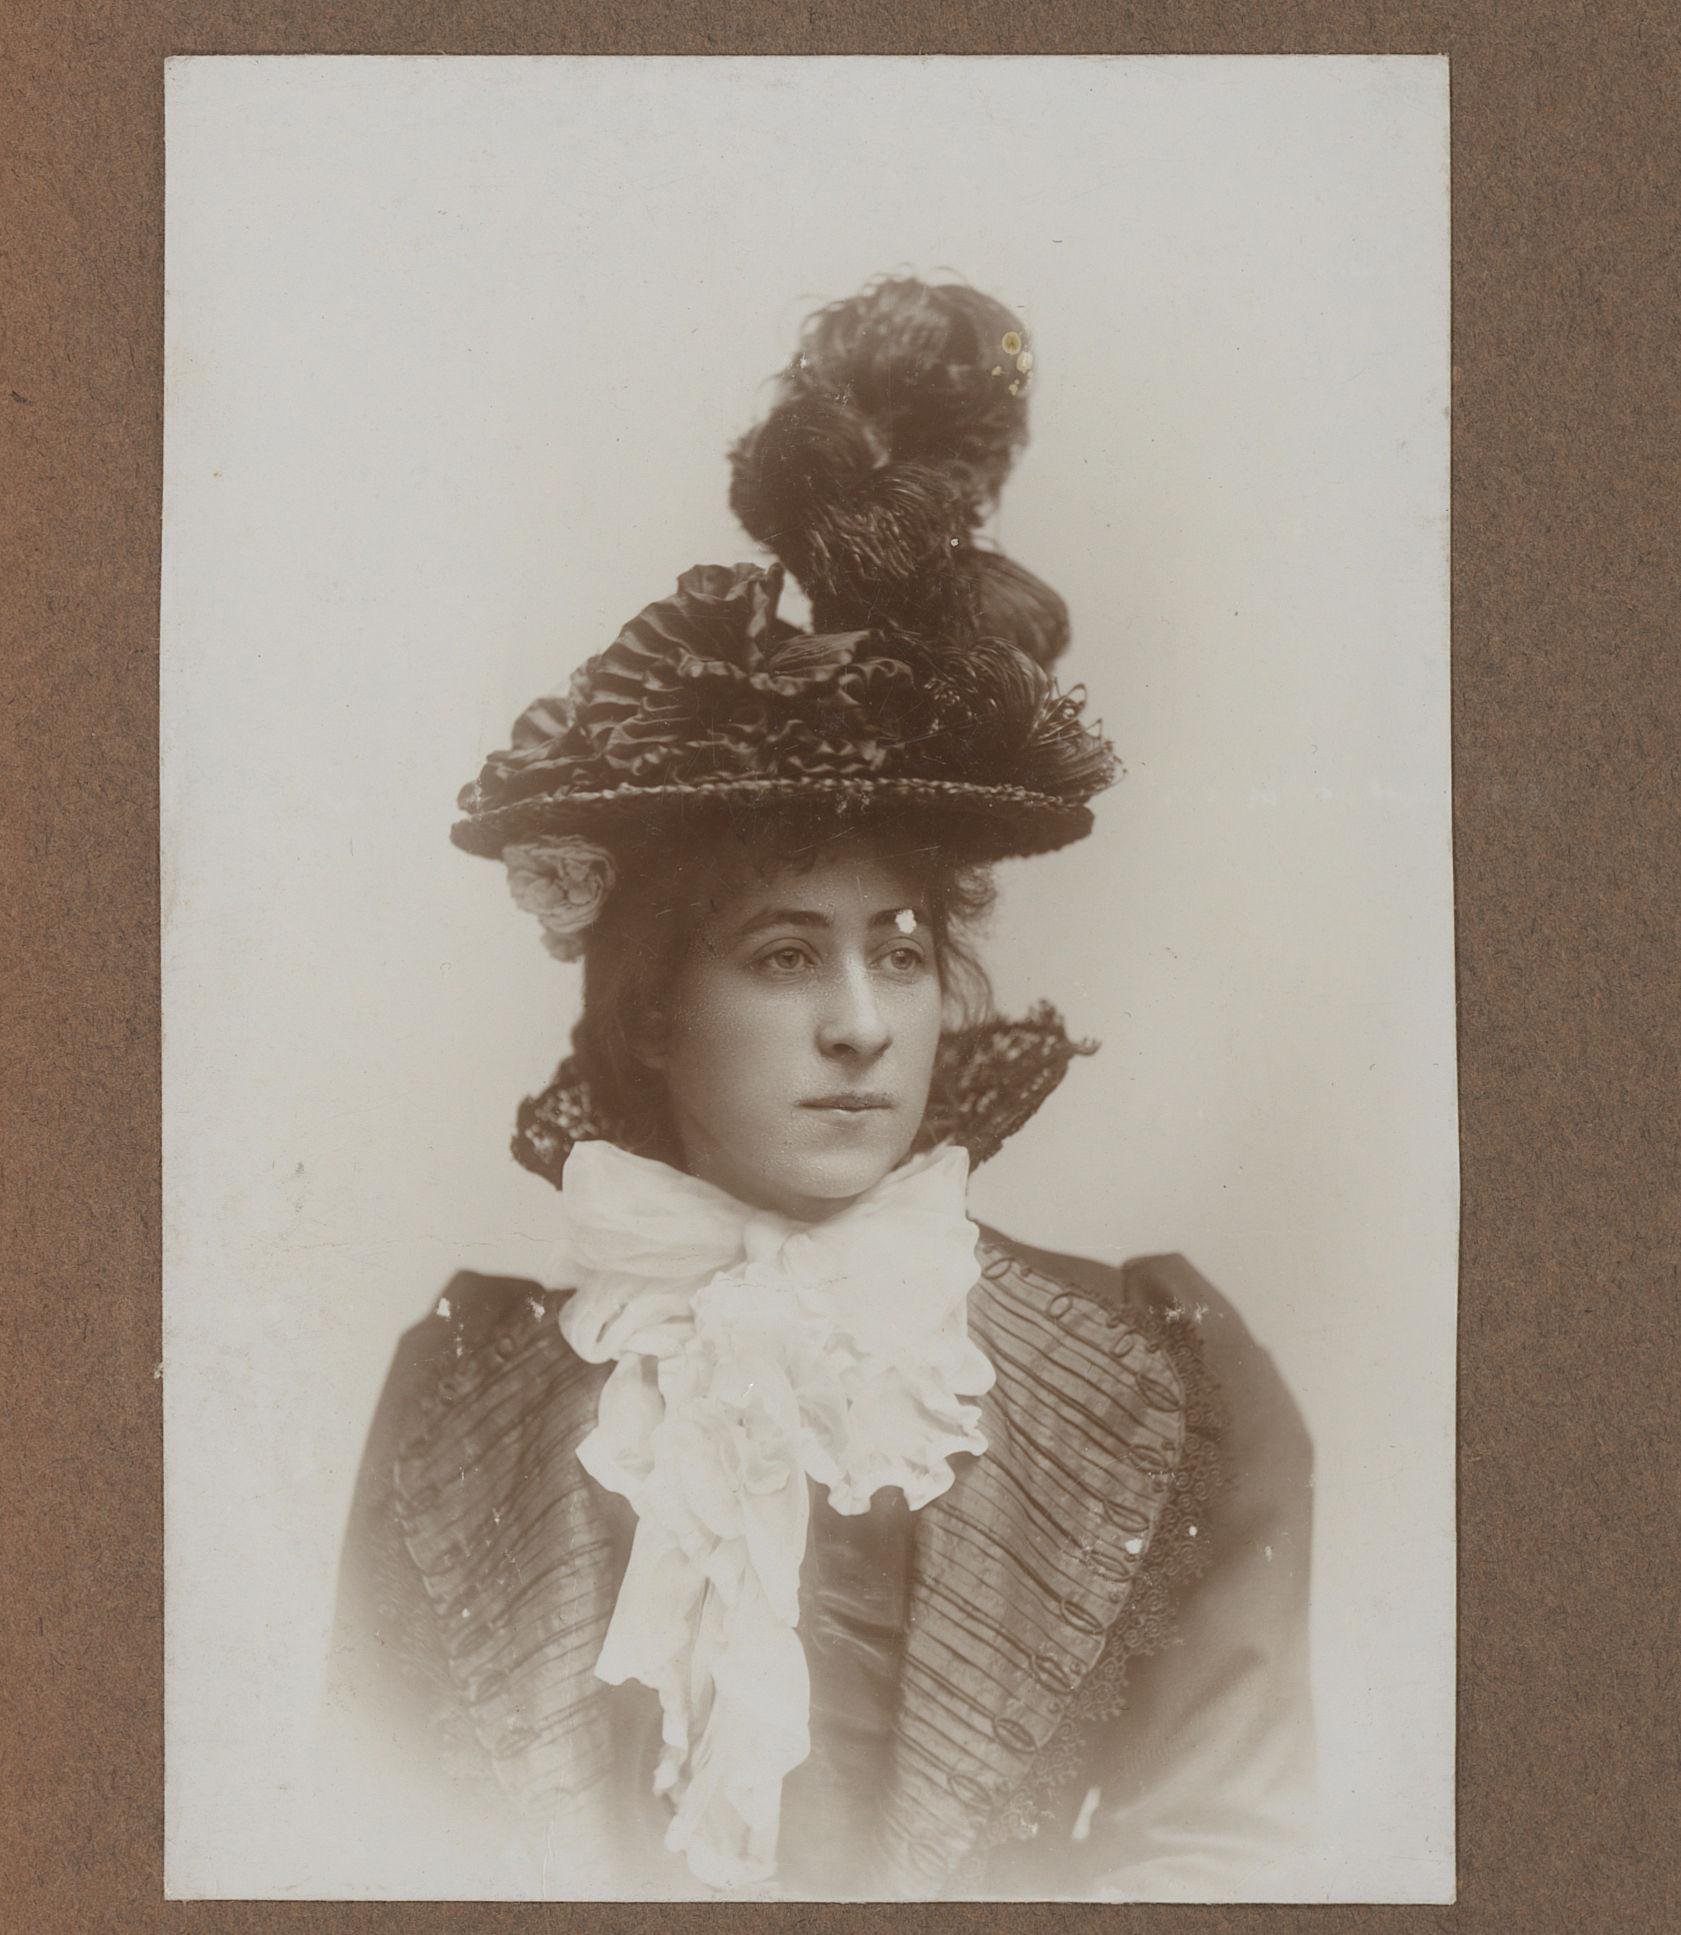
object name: photograph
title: Portret van jonge vrouw met hoed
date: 1870-1920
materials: photographic support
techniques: photography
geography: netherlands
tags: netherlands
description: Foto op bruin albumblad 36 van familiealbum van Alphons Diepenbrock.